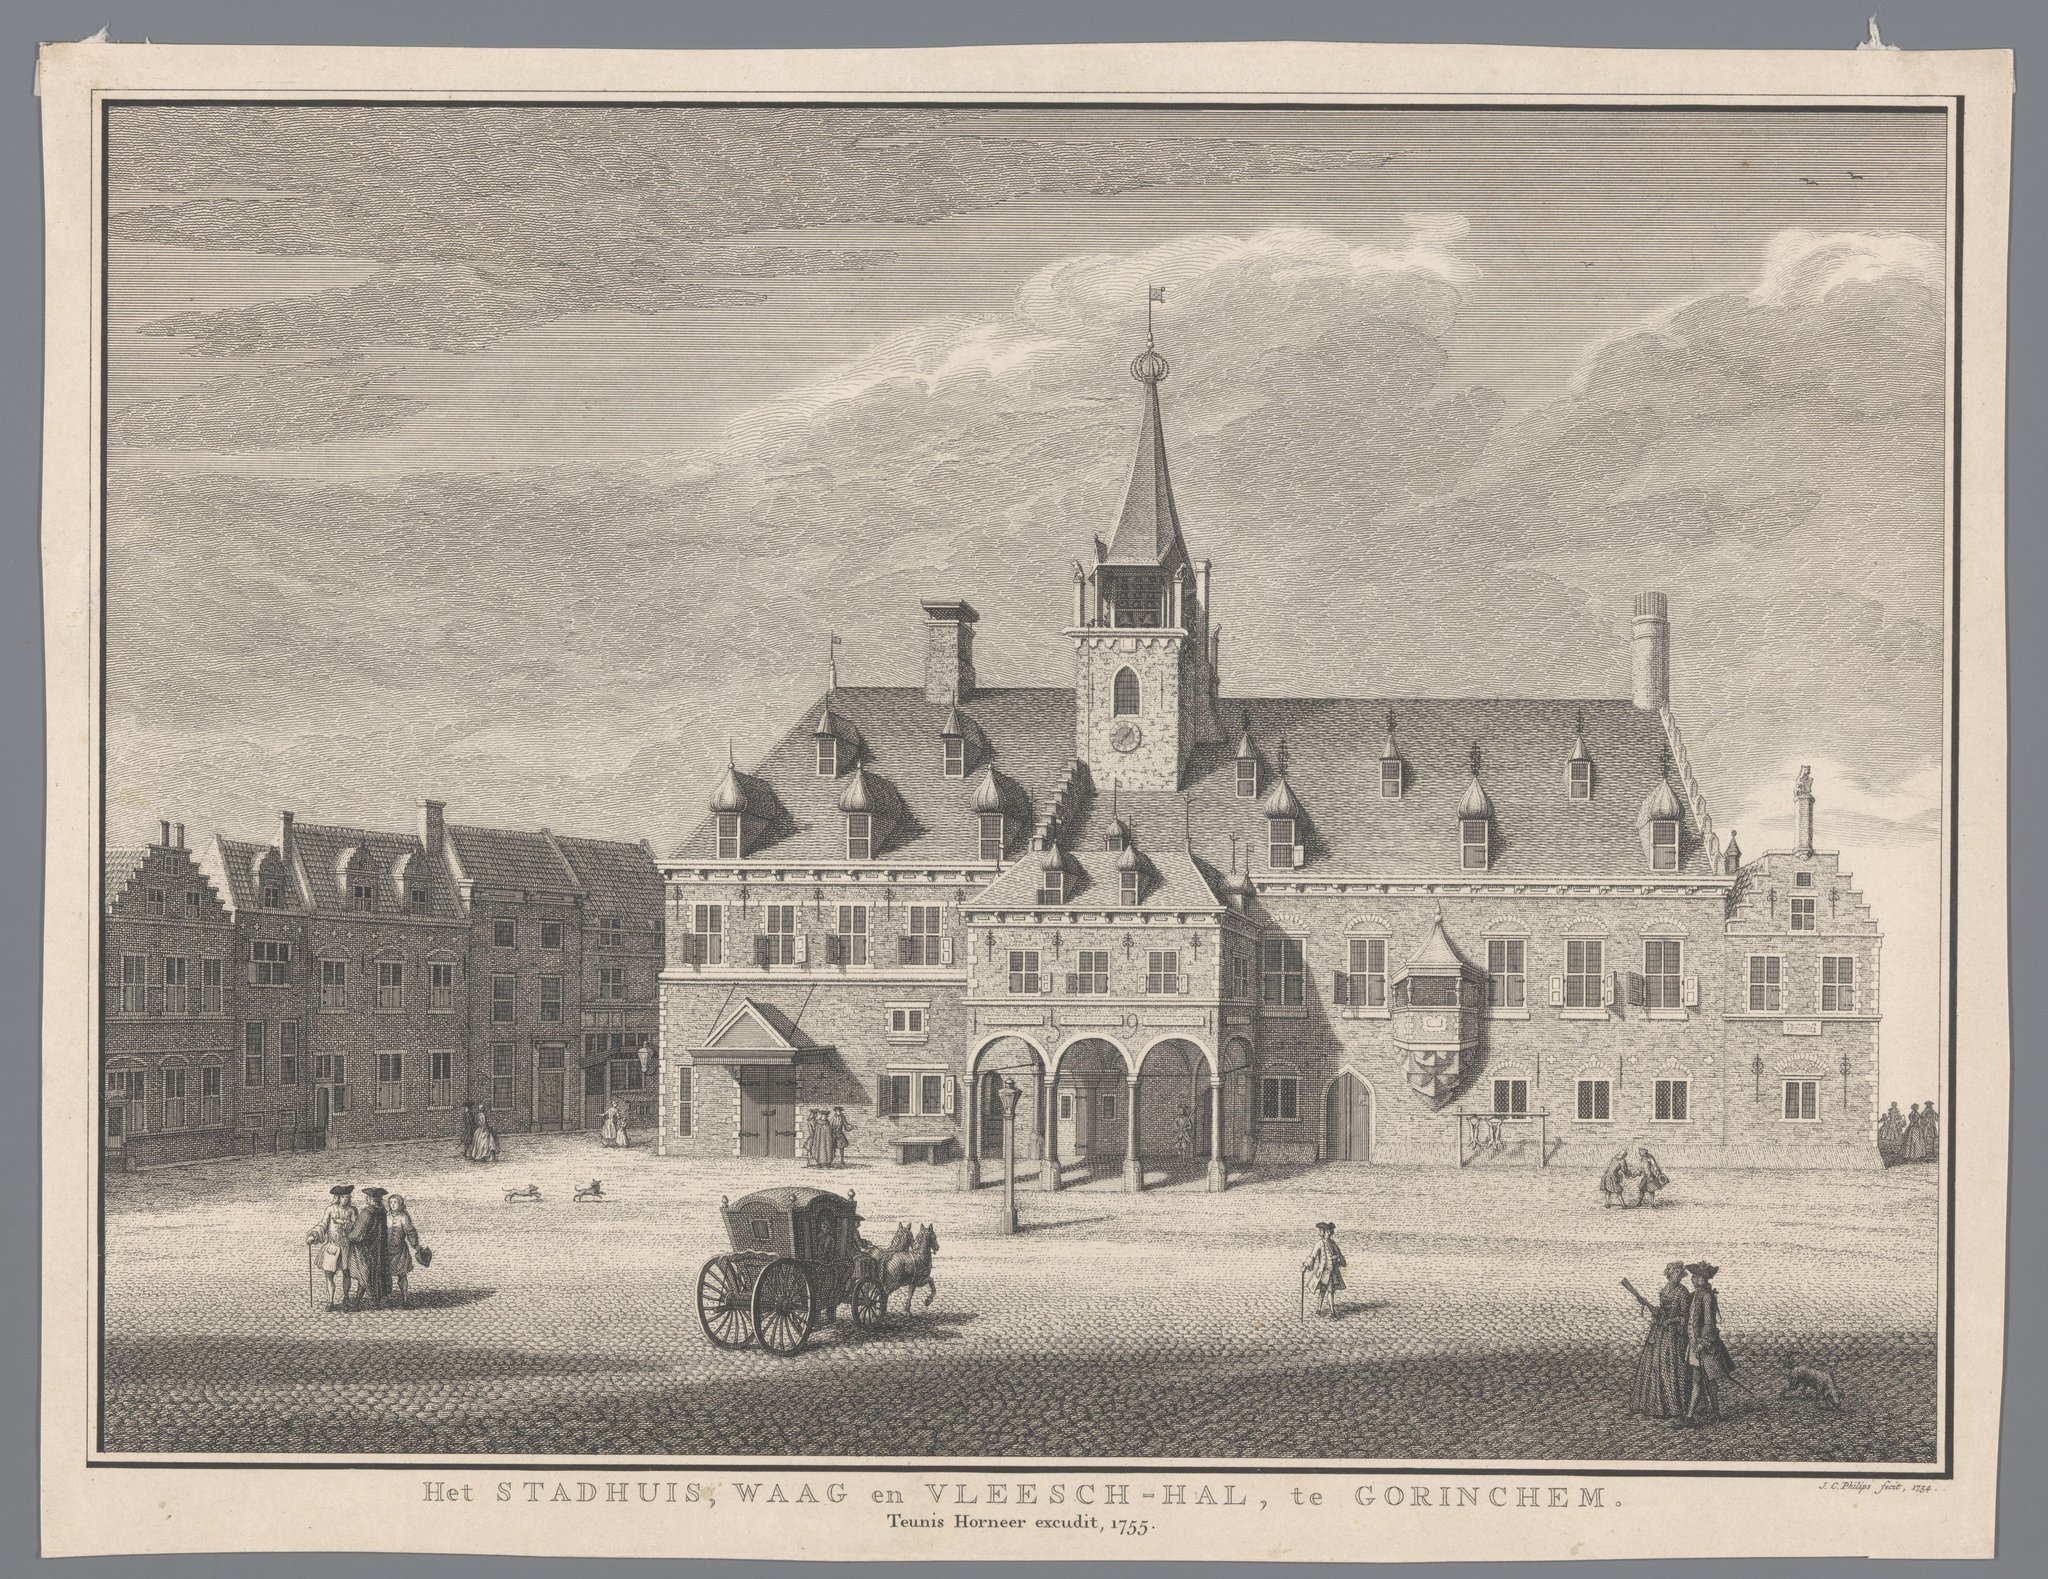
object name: print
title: Het Stadhuis, Waag en Vleesch-Hal, te Gorinchem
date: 1754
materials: paper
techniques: etching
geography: gorinchem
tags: townhall, exterior ~ representation of a building, weigh-house, market-hall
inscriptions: date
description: Prent uit: Zomeren, Cornelis van. Beschryvinge der Stadt Gorinchem, en landen van Arkel (...). Gorinchem: Teunis Horneer, 1755, tussen p. 114 en 115.